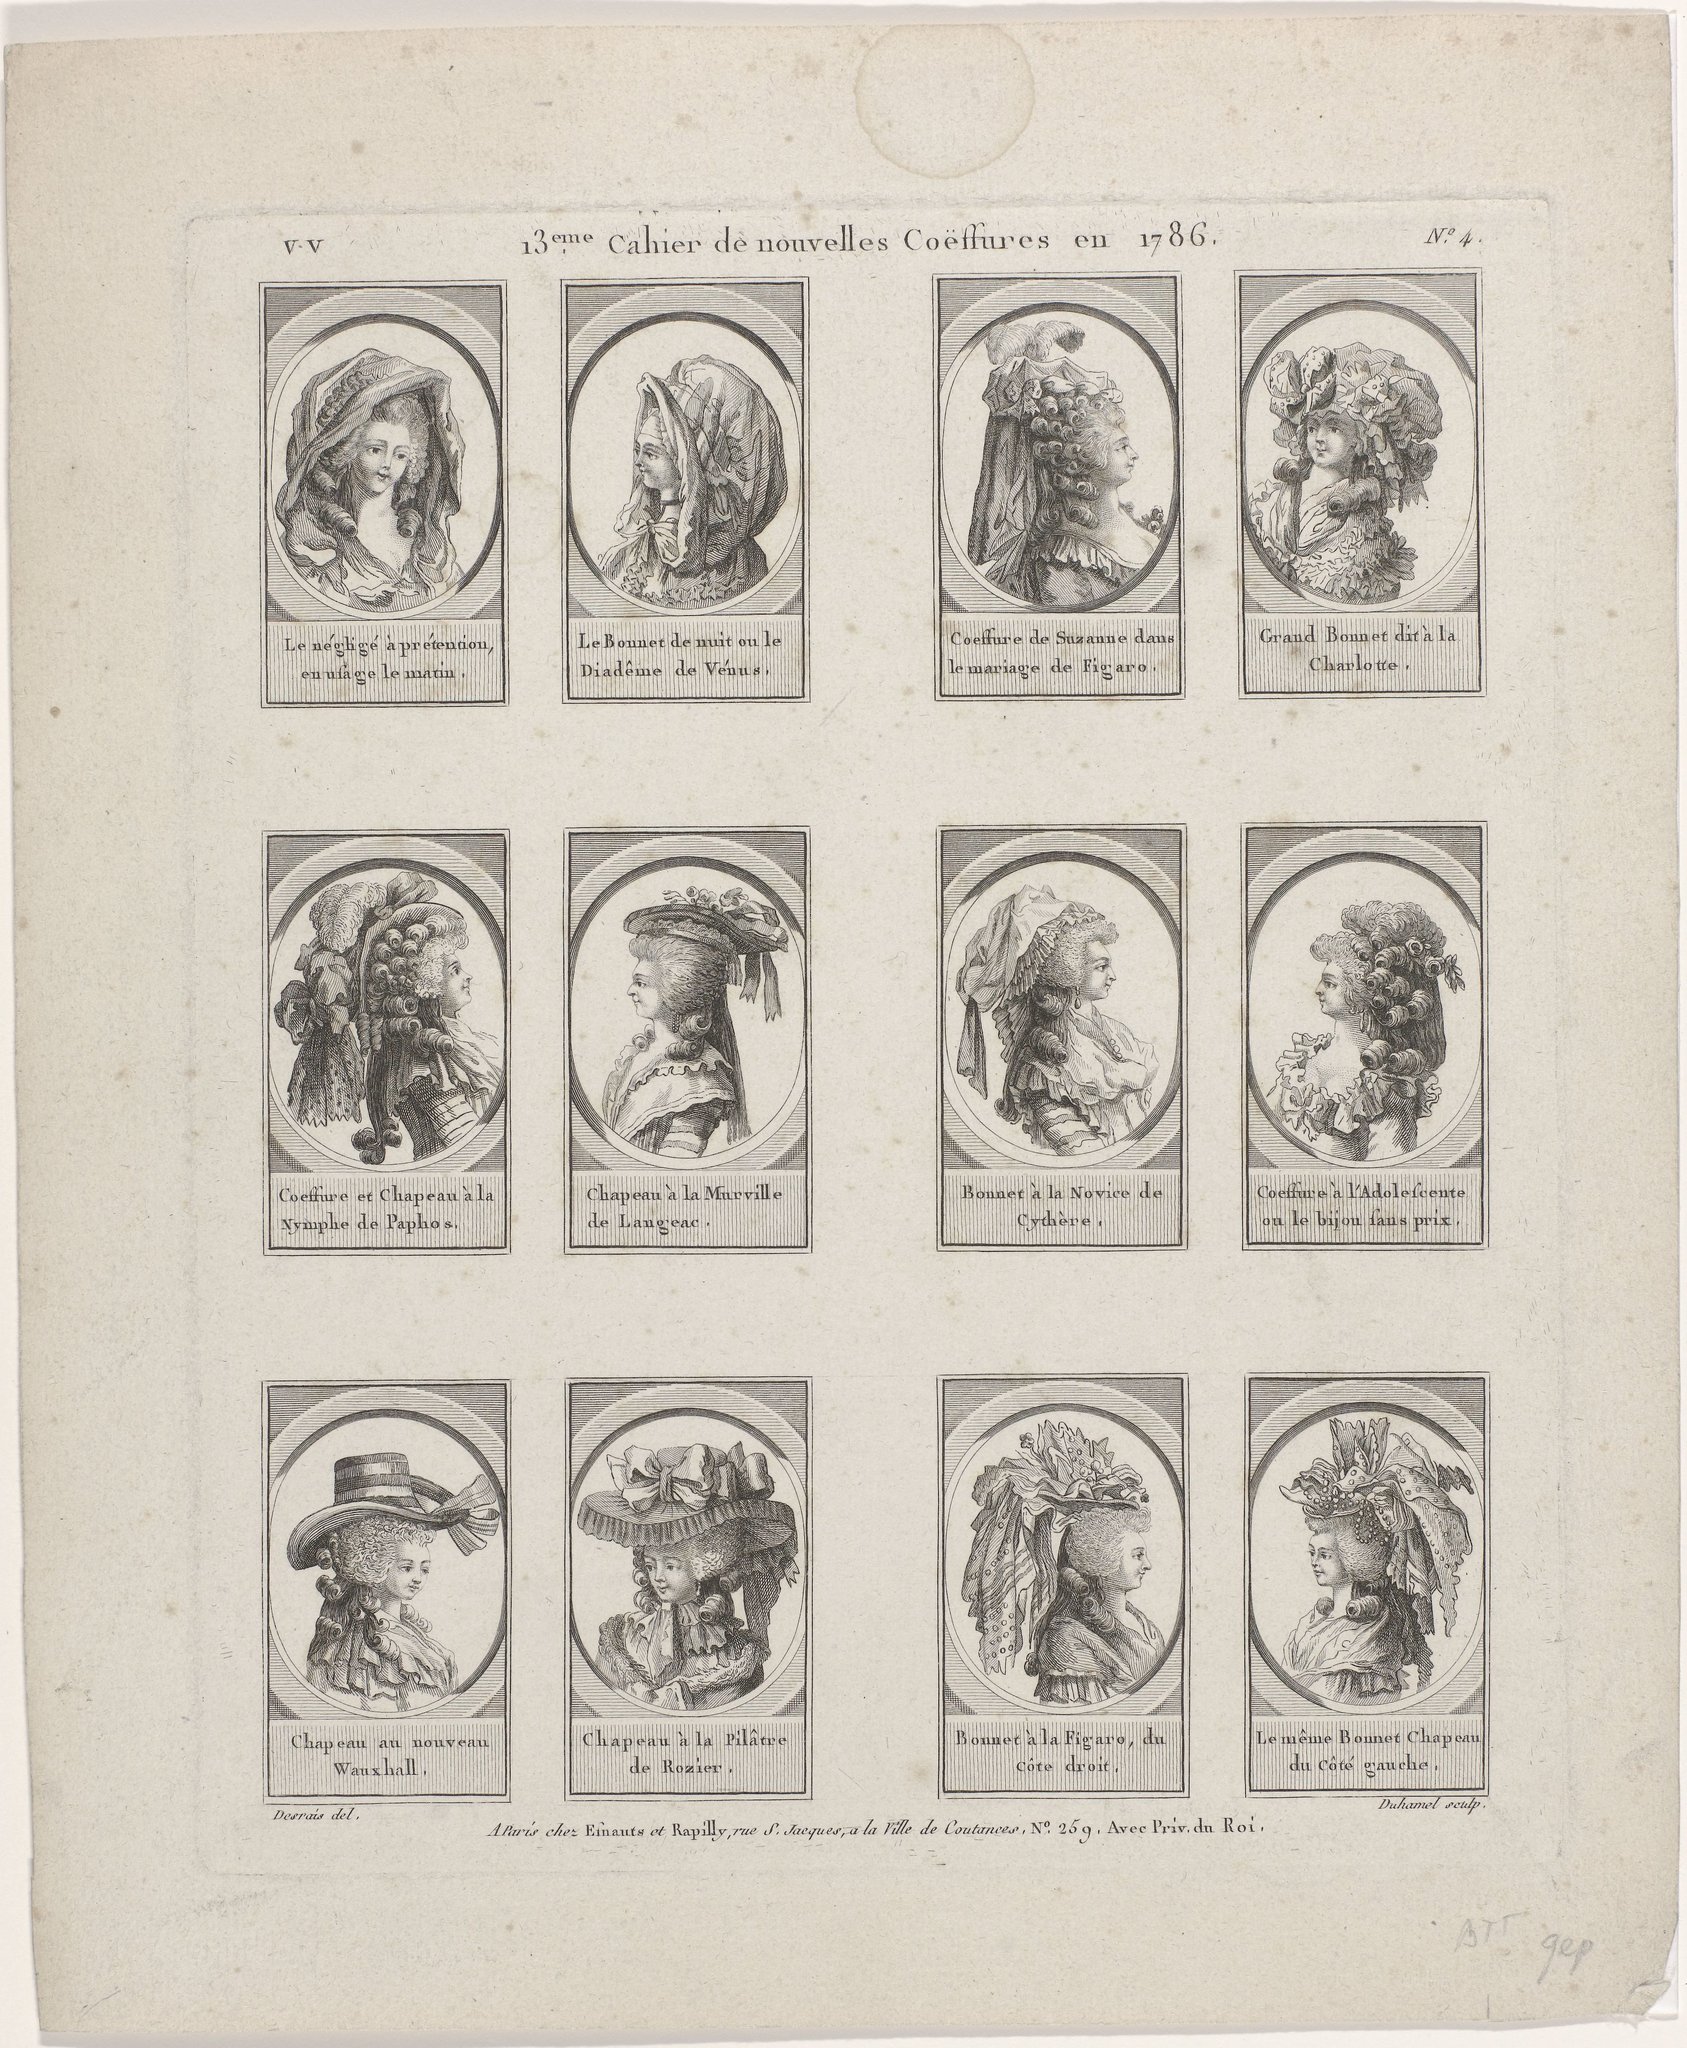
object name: fashion print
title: Gallerie des Modes et Costumes Français, 1785-1786, vv 4 : La négligé à prétention en usage le matin (...)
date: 1785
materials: paper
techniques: engraving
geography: paris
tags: clothing for the upper part of the body (+ women's clothes), ear-rings (+ women's clothes), styles of hairdress - aa - ~ women, head-gear: cap (+ women's clothes), head-gear (bonnet) (+ women's clothes), fashion plates, head-gear: hat (+ women's clothes), neck-gear ~ clothing (+ women's clothes)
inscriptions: address: ‘A Paris chez Esnauts et Rapilly, rue St. Jacques, a la Ville de Coutances, No.259, Avec Priv. du Roi..’, title: ‘13eme Cahier de nouvelles Coëffures en 1786.’, inscription: ‘Chapeau au nouveau Wauxhall. / Chapeau à la Pilâtre de Rozier. / Bonnet à la Figaro, du côte droit. / Le même Bonnet Chapeau du Côté gauche.’, inscription: ‘Coeffure et Chapeau à la Nymphe de Paphos. / Chapeau à la Murville de Langeac / Bonnet à la Novice de Cythère / Coeffure à l'Adolescente ou le bijou sans prix’, inscription: ‘Le négligé à prêtention, en usage le matin. / Le Bonnet de nuit ou le Diadême de Vénus. / Coeffure de Suzanne dans le mariage de Figaro / Grand Bonnet et dit à la Charlotte.’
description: Twaalf verschillende dameskapsels met hoeden en mutsen, in drie rijen van vier, verdeeld in kaders met ovalen. Van linksboven naar rechtsonder: 'Le négligé à prêtention, en usage le matin. Le Bonnet de nuit ou le Diadême de Vénus. Coeffure de Suzanne dans le mariage de Figaro. Grand Bonnet et dit à la Charlotte. Coeffure et Chapeau à la Nymphe de Paphos. Chapeau à la Murville de Langeac. Bonnet à la Novice de Cythère. Coeffure à l'Adolescente ou le bijou sans prix. Chapeau au nouveau Wauxhall. Chapeau à la Pilâtre de Rozier. Bonnet à la Figaro, du côte droit. Le même Bonnet Chapeau du Côté gauche.' Prent uit de serie 13e suite de Coeffures à la mode en 1785, Gallerie des Modes et Costumes Français.